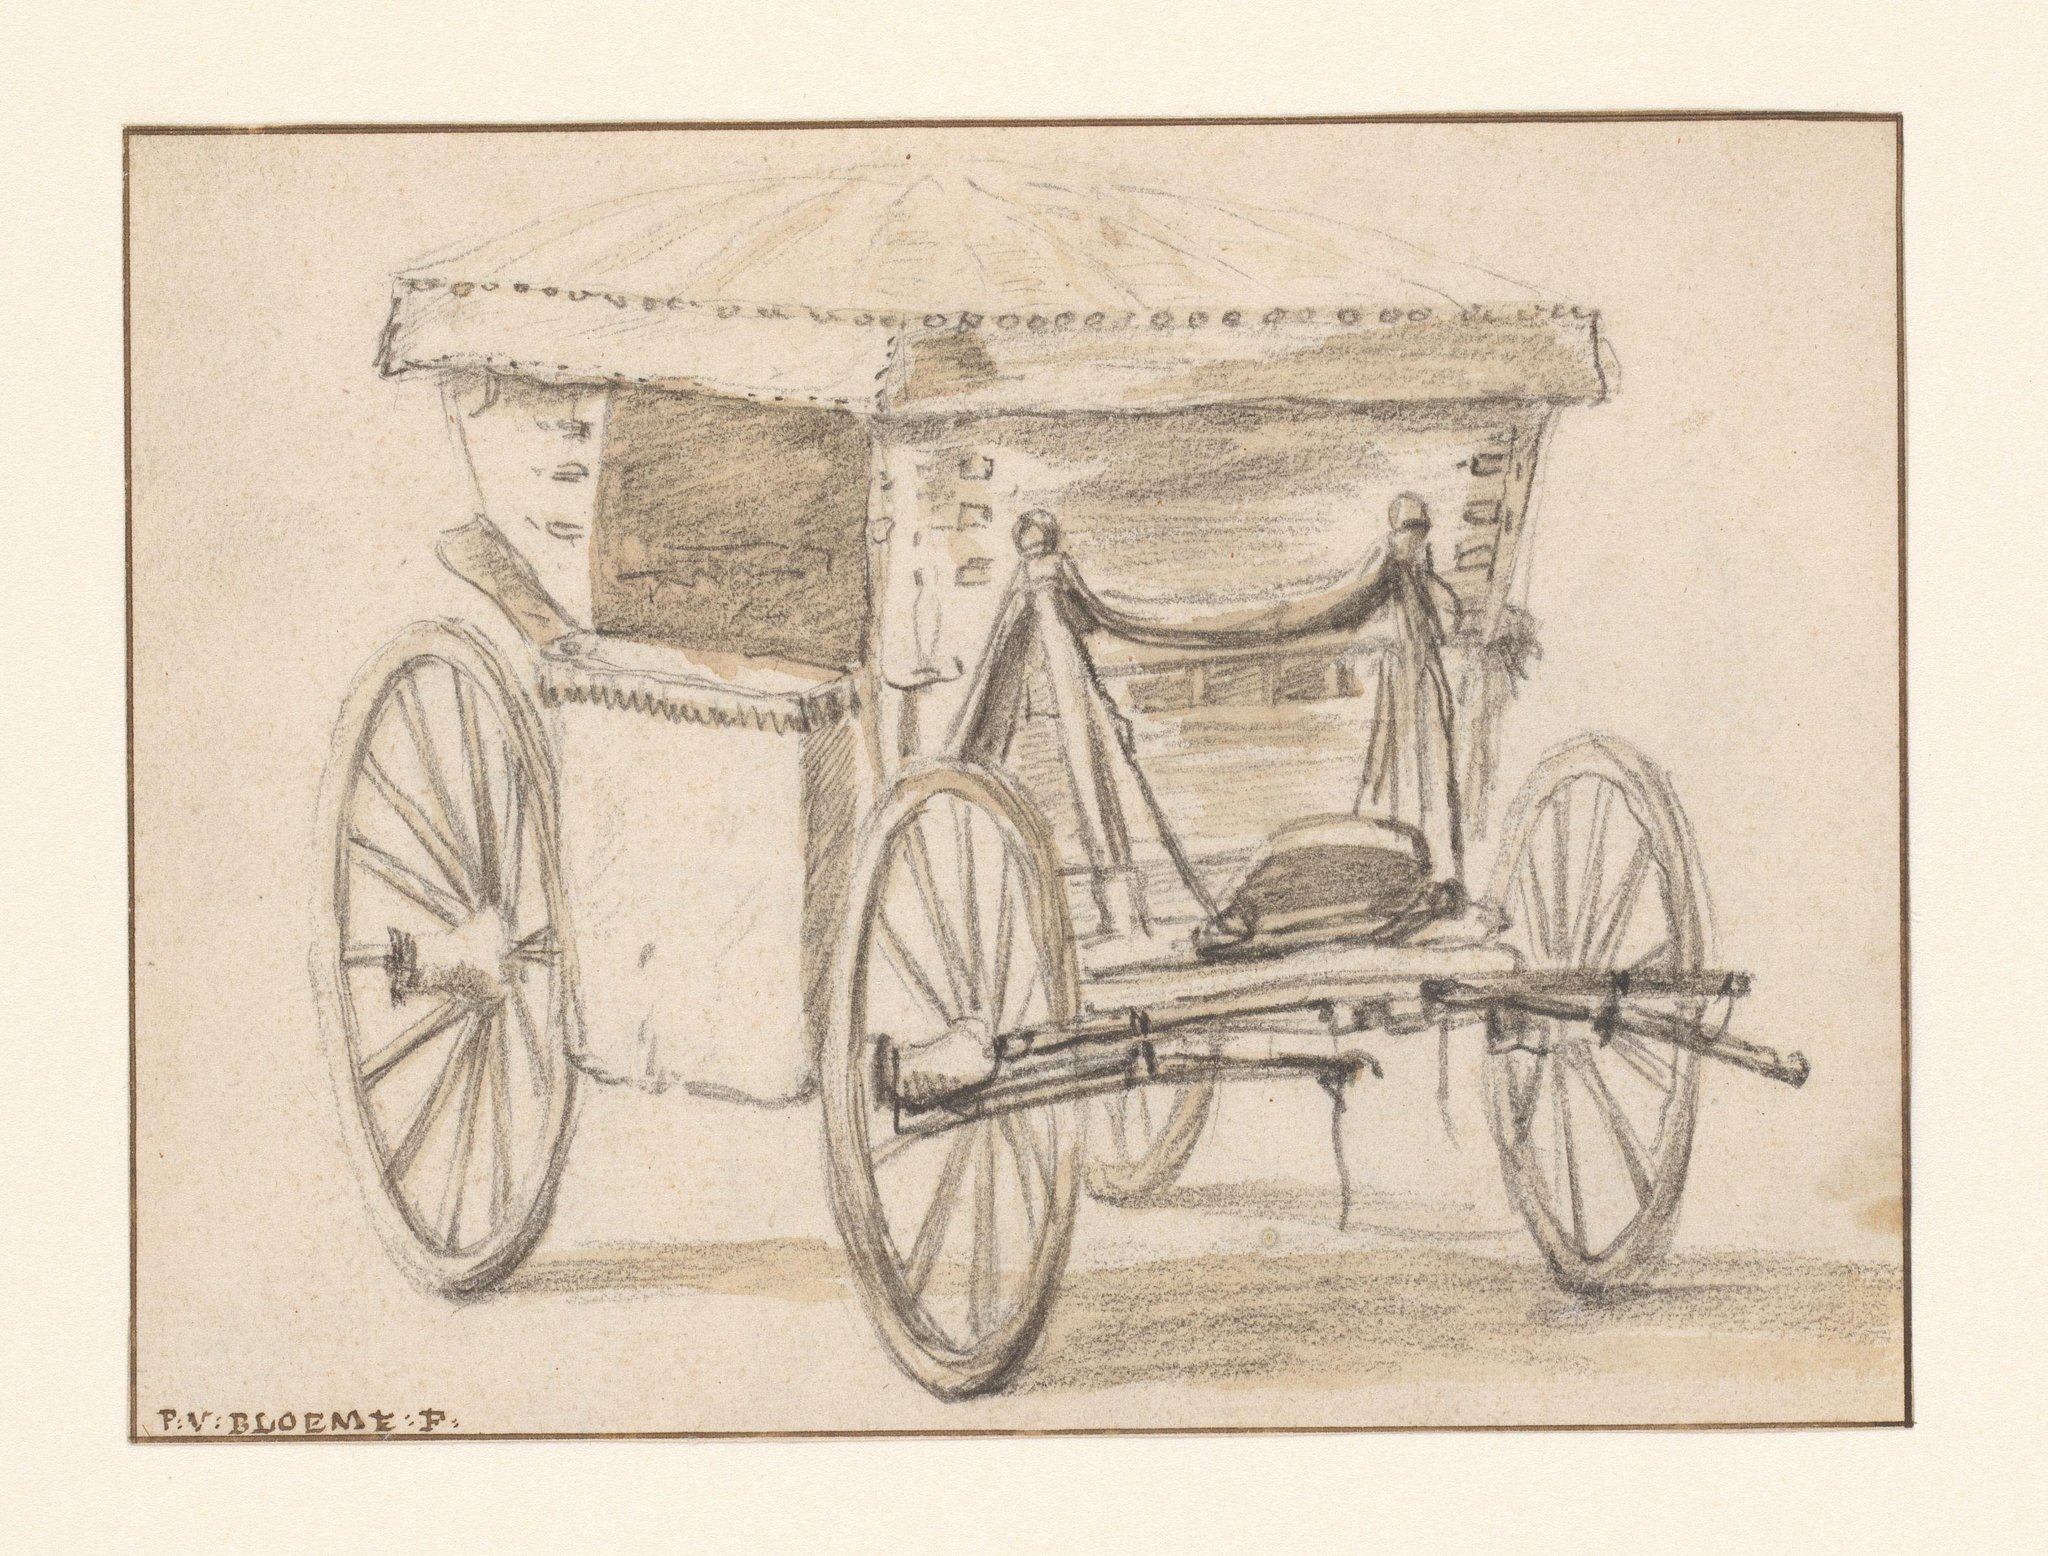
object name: drawing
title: Carriage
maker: pieter van bloemen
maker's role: draughtsman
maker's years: 1657-1720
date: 1667-1720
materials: chalk, paper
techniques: brush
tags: four-wheeled, animal-drawn vehicle, e.g.: cab, carriage, coach